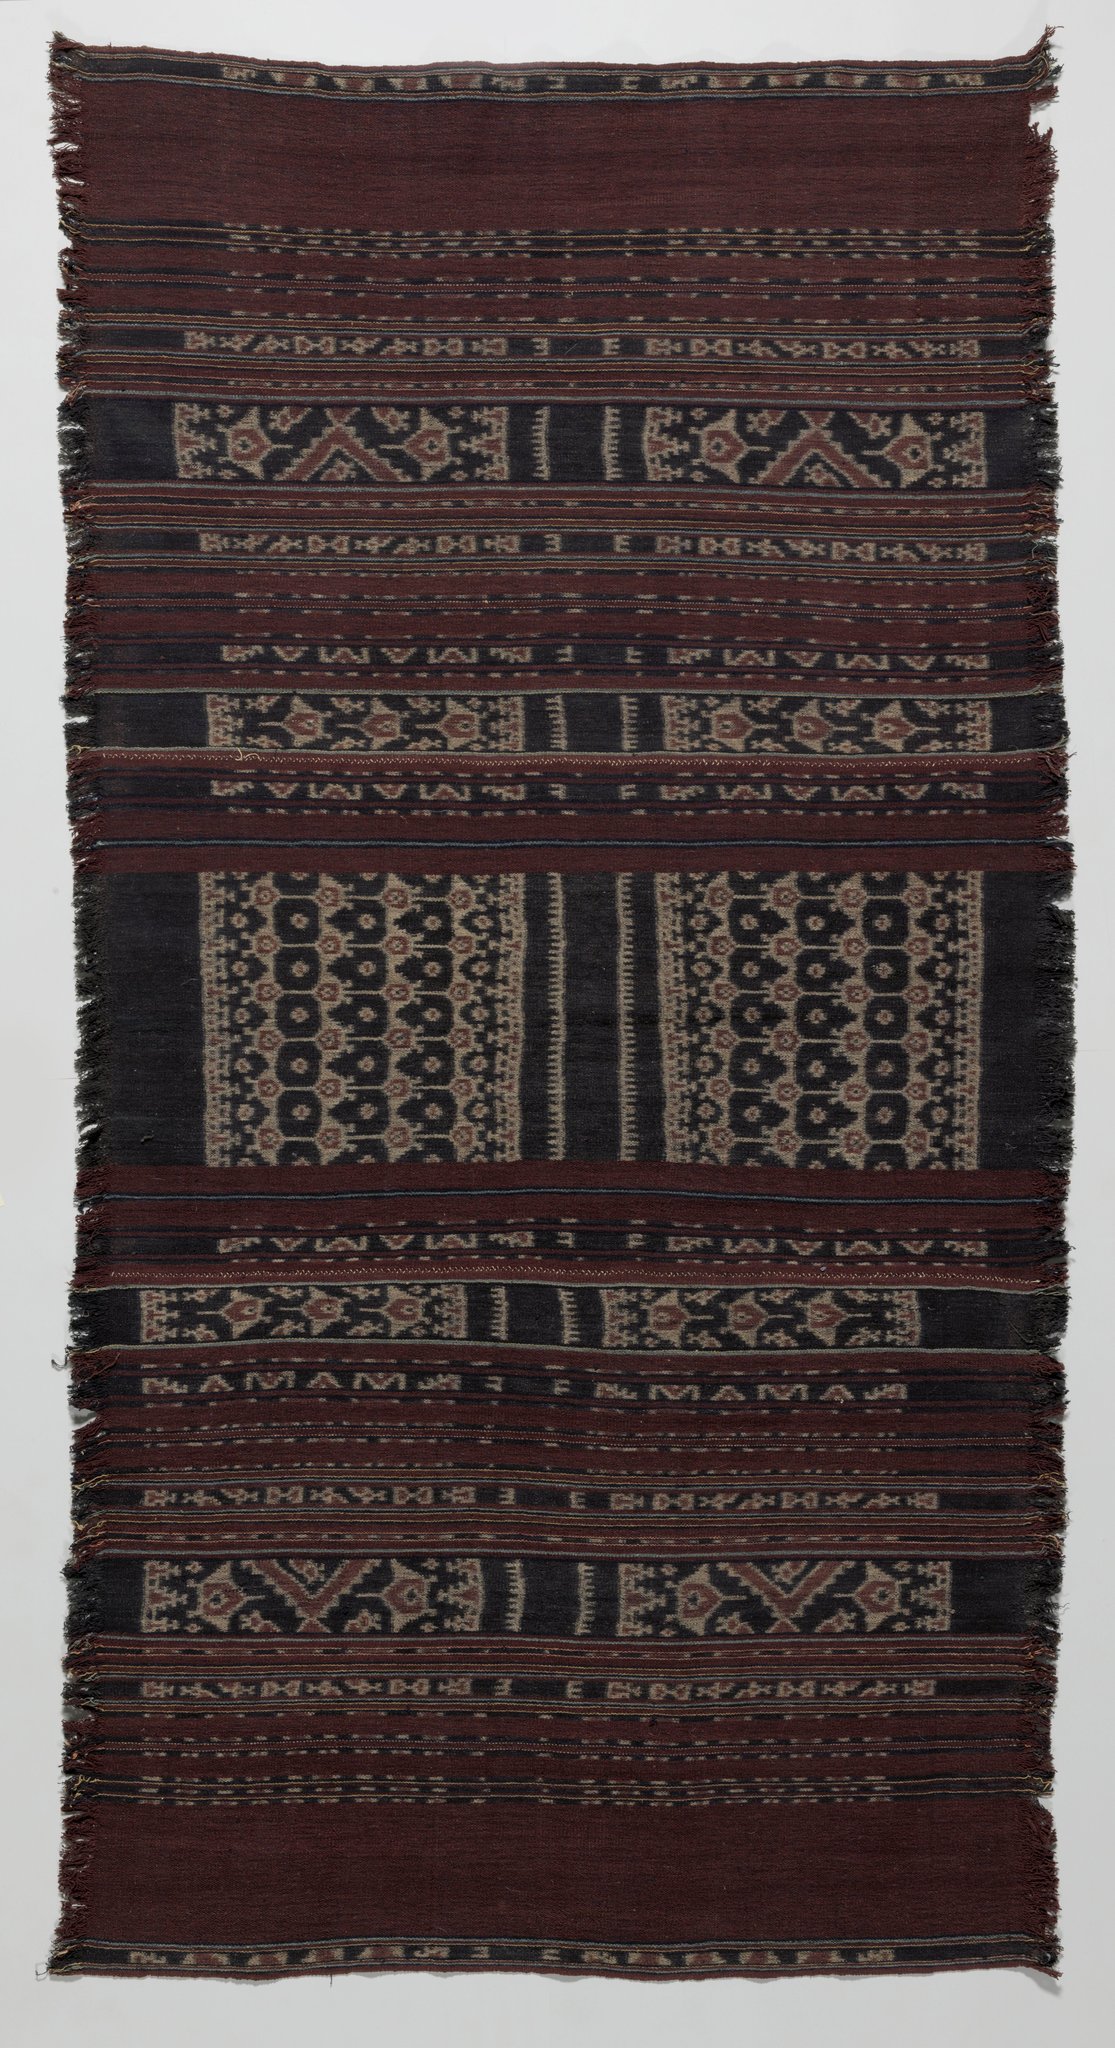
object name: cloth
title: Doek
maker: Anonymous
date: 1900-1949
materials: cotton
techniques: weave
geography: flores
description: Driedelig doek met geometrische motieven, bruidsgift.